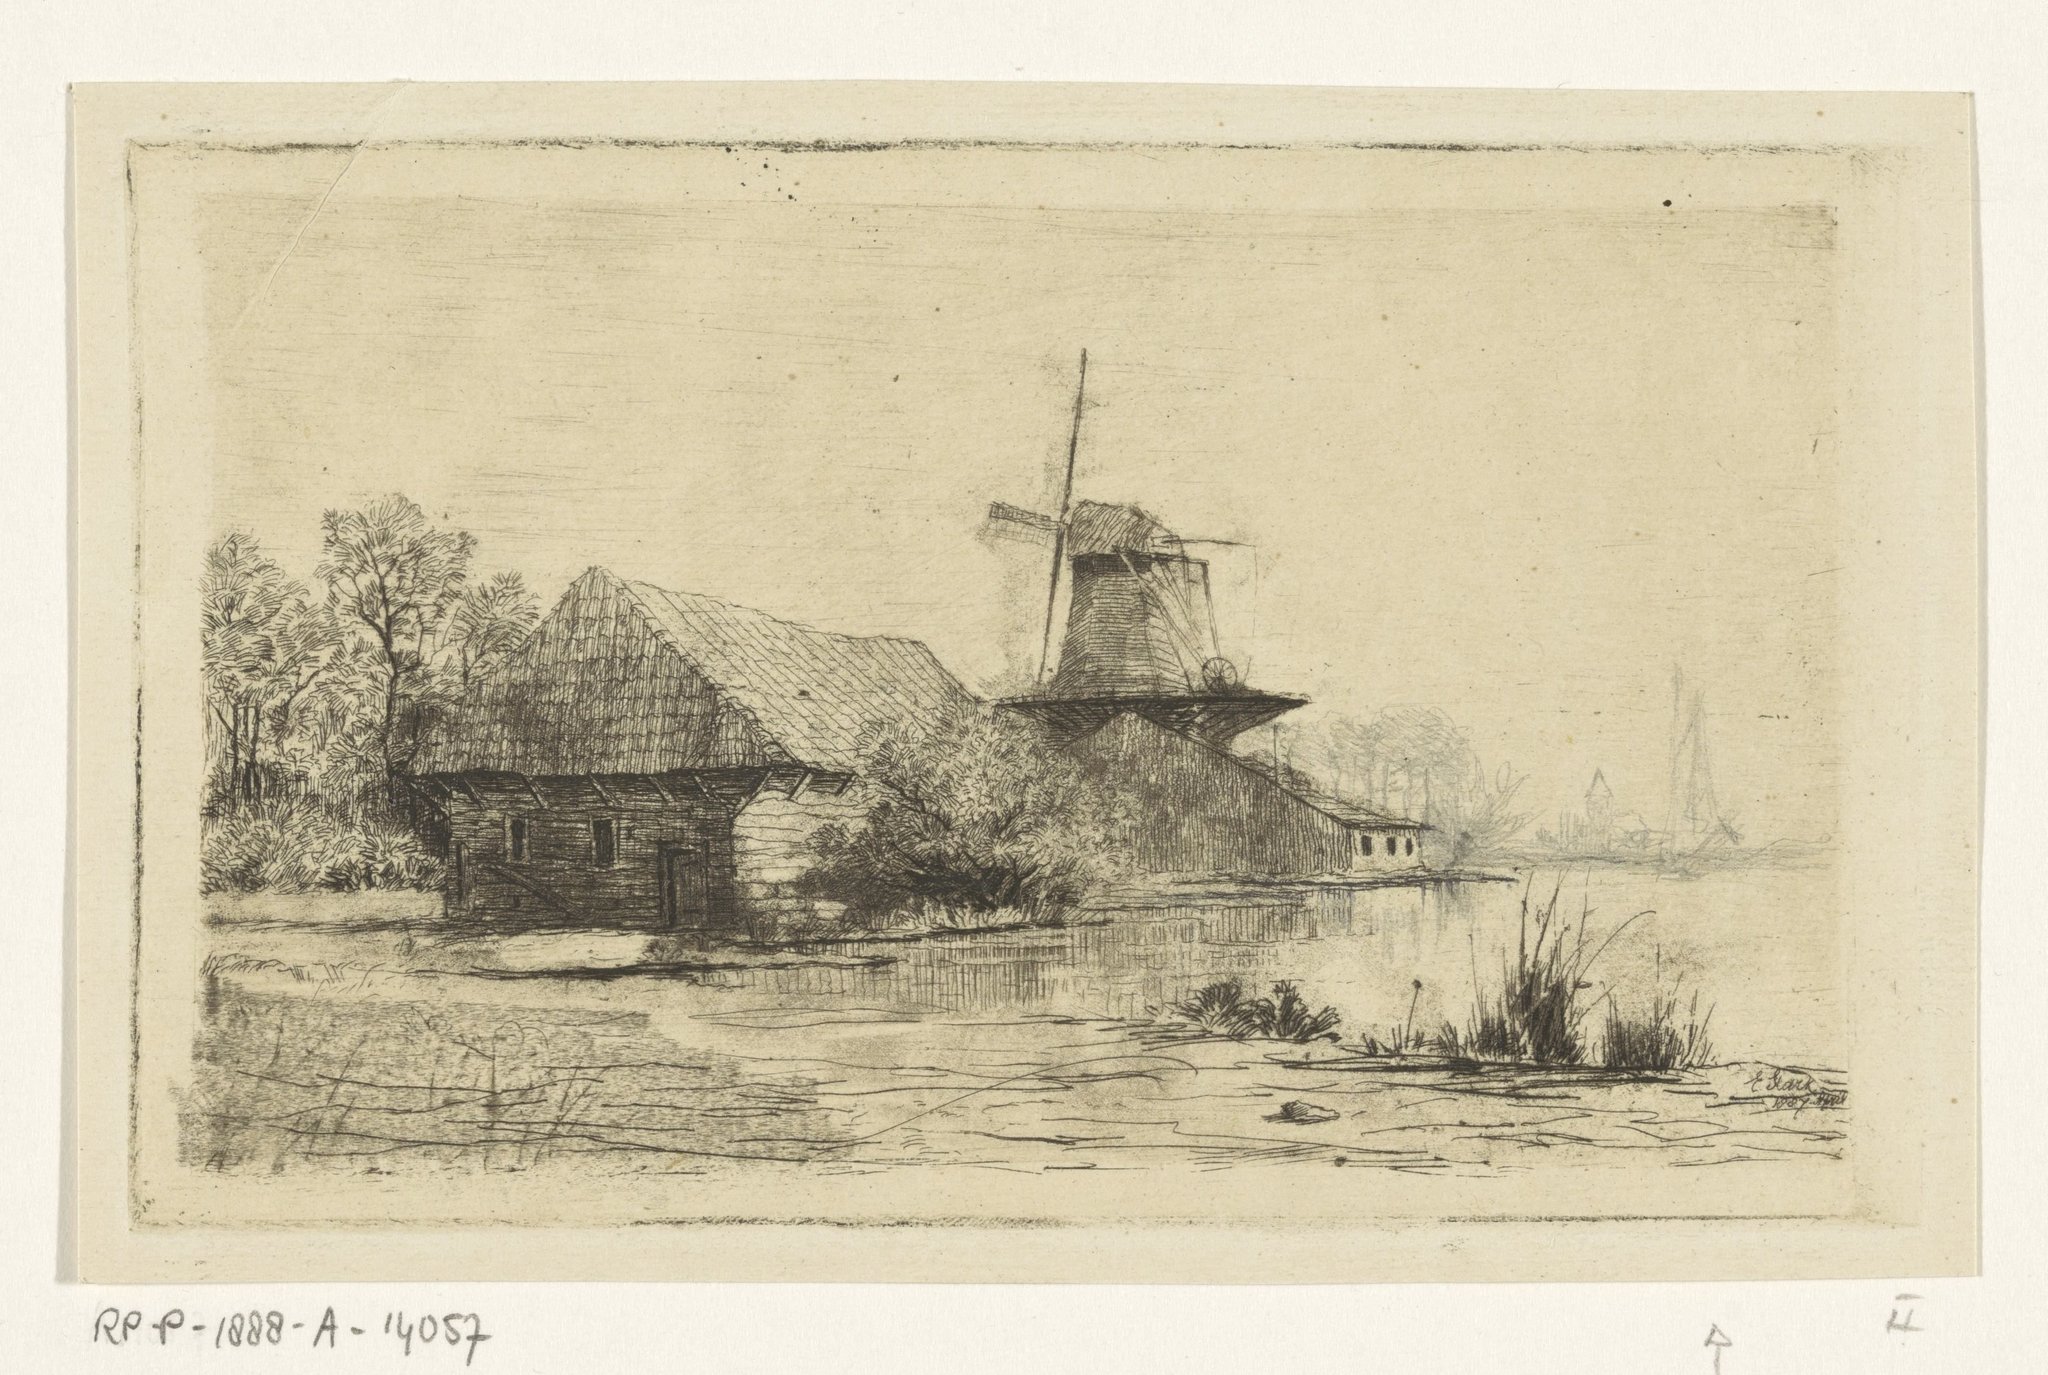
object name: print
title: Schuur en molen aan het water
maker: elias stark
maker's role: draughtsman, print maker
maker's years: 1849-1933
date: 1804-1887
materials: paper, pencil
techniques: aquatint, etching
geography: nieuwer-amstel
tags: windmill in landscape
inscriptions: collector's mark: Lugt 2228